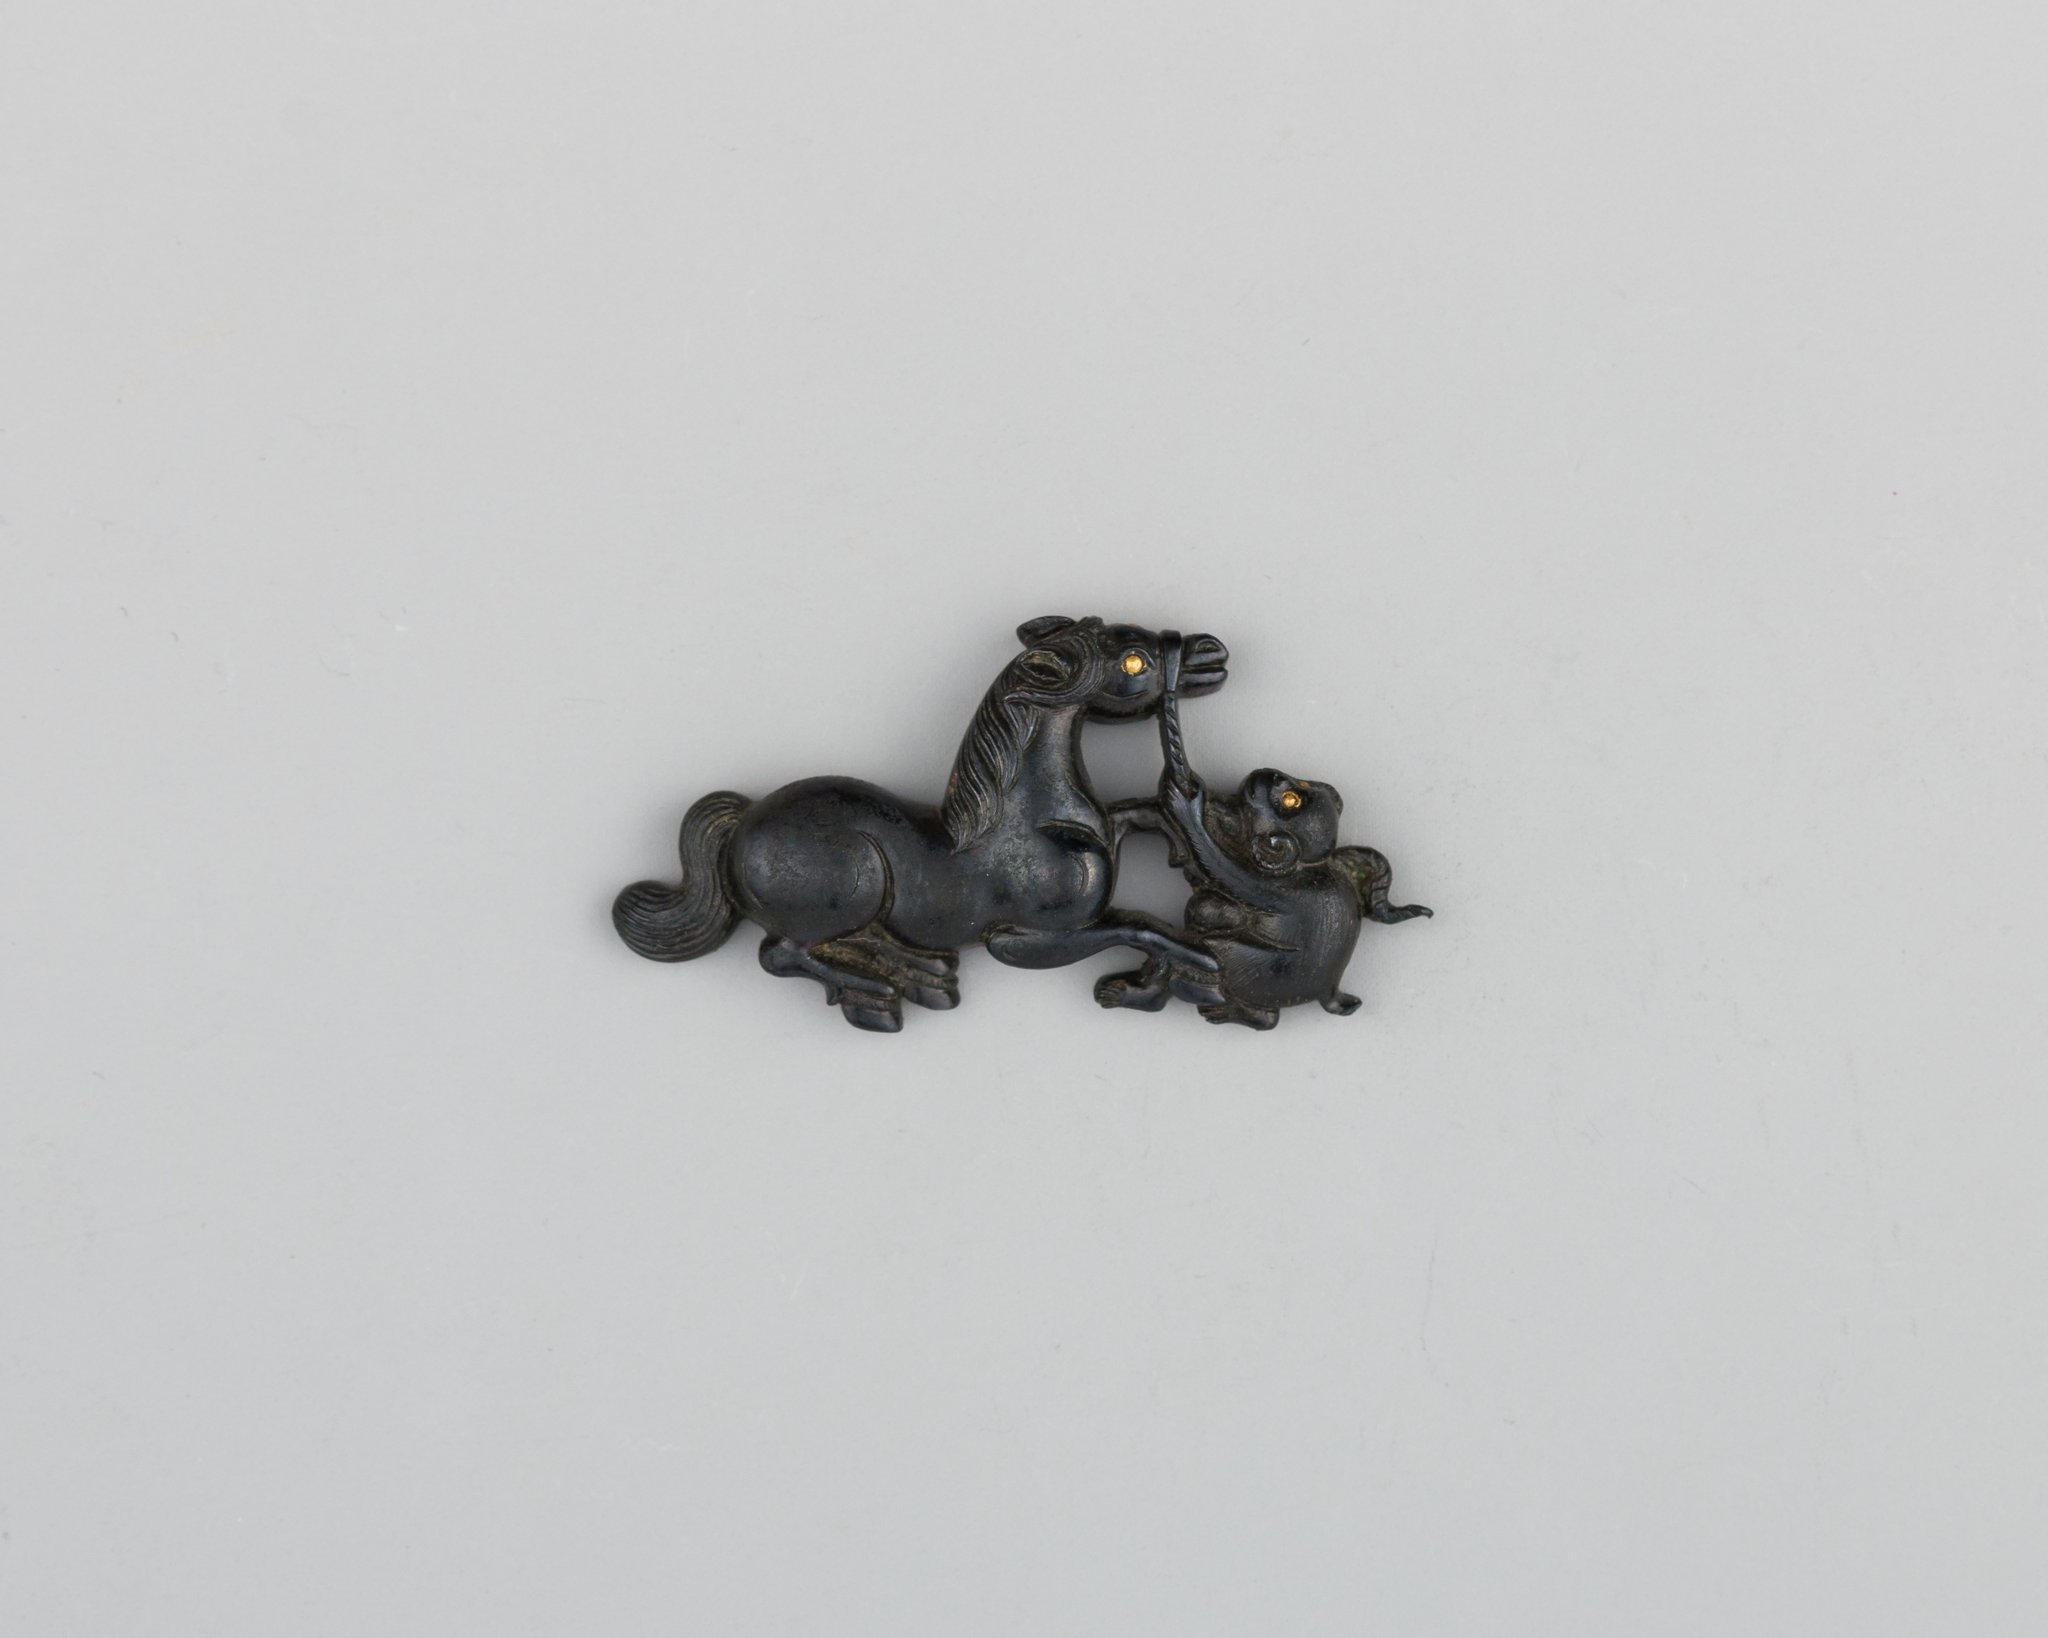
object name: sword grip ornament menuki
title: Sword-Grip Ornament (Menuki)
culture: japanese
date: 1701-1733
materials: gold alloy, gold, silver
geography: japan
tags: horses